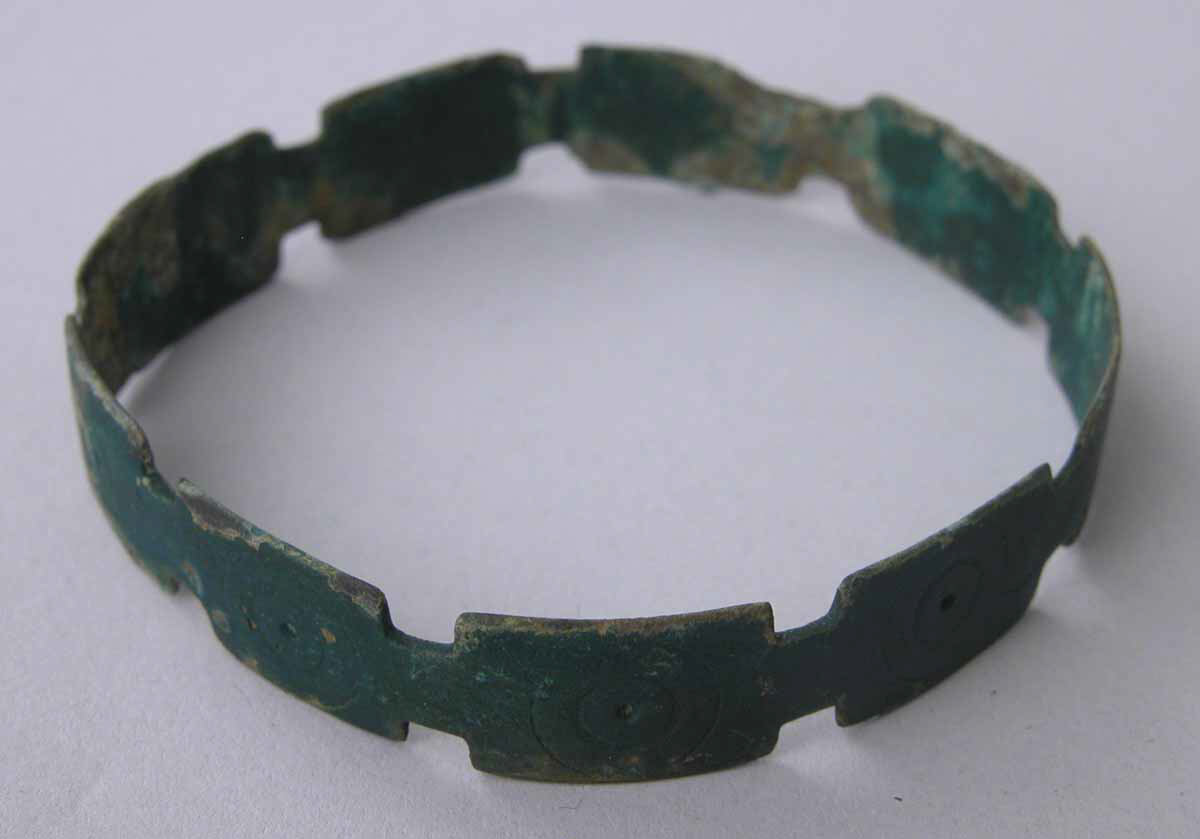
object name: bracelet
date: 501-800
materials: bronze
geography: egypt